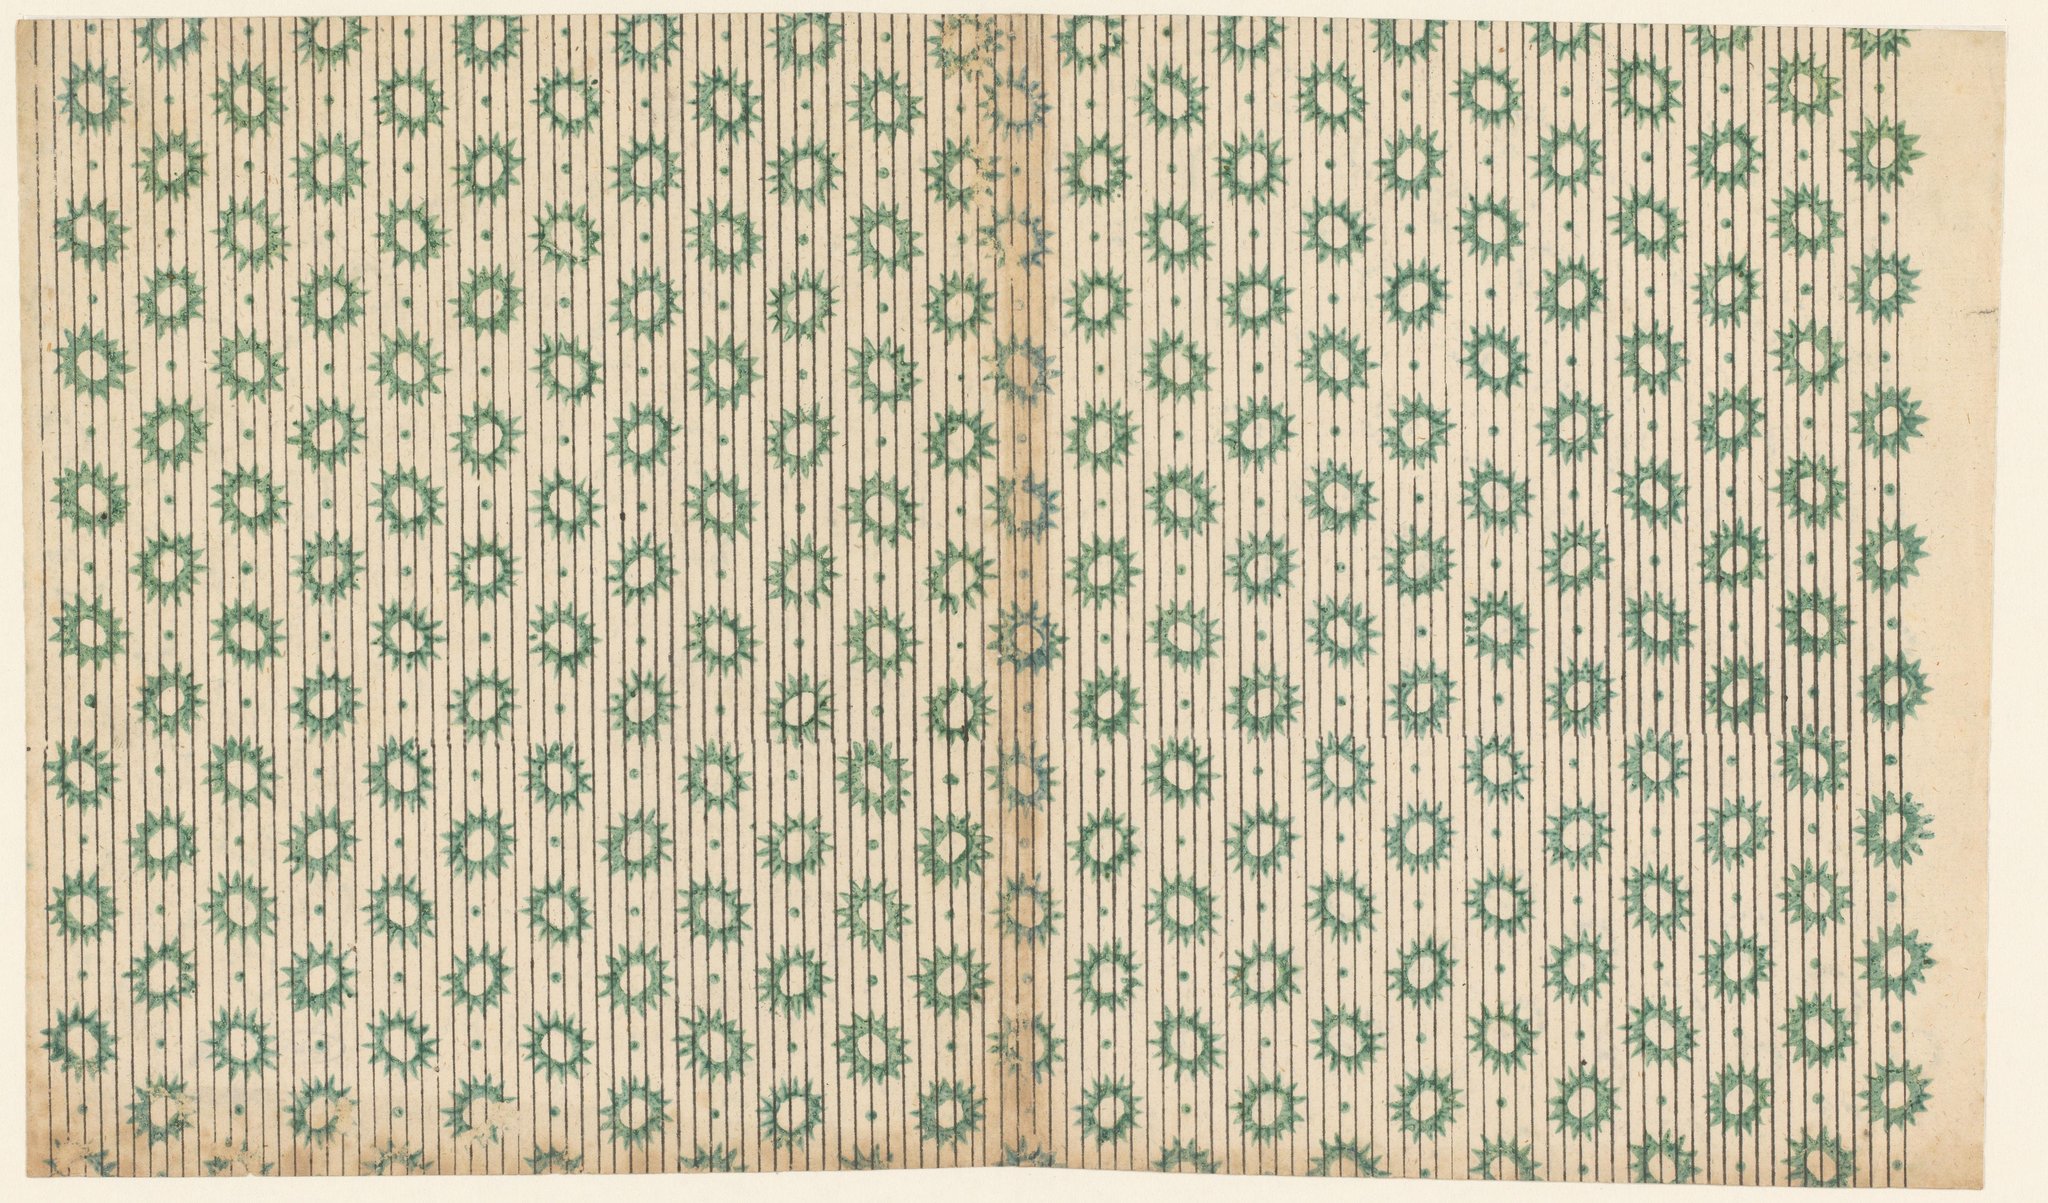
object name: printed paper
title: Blad met strooipatroon van bloemen onder een doorlopend lijnenfond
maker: Anonymous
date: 1700-1850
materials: paper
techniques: printing block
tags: ornament derived from plant forms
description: Blad met strooipatroon van bloemen onder een doorlopend verticaal lijnenfond. Gebruikt als omslag.